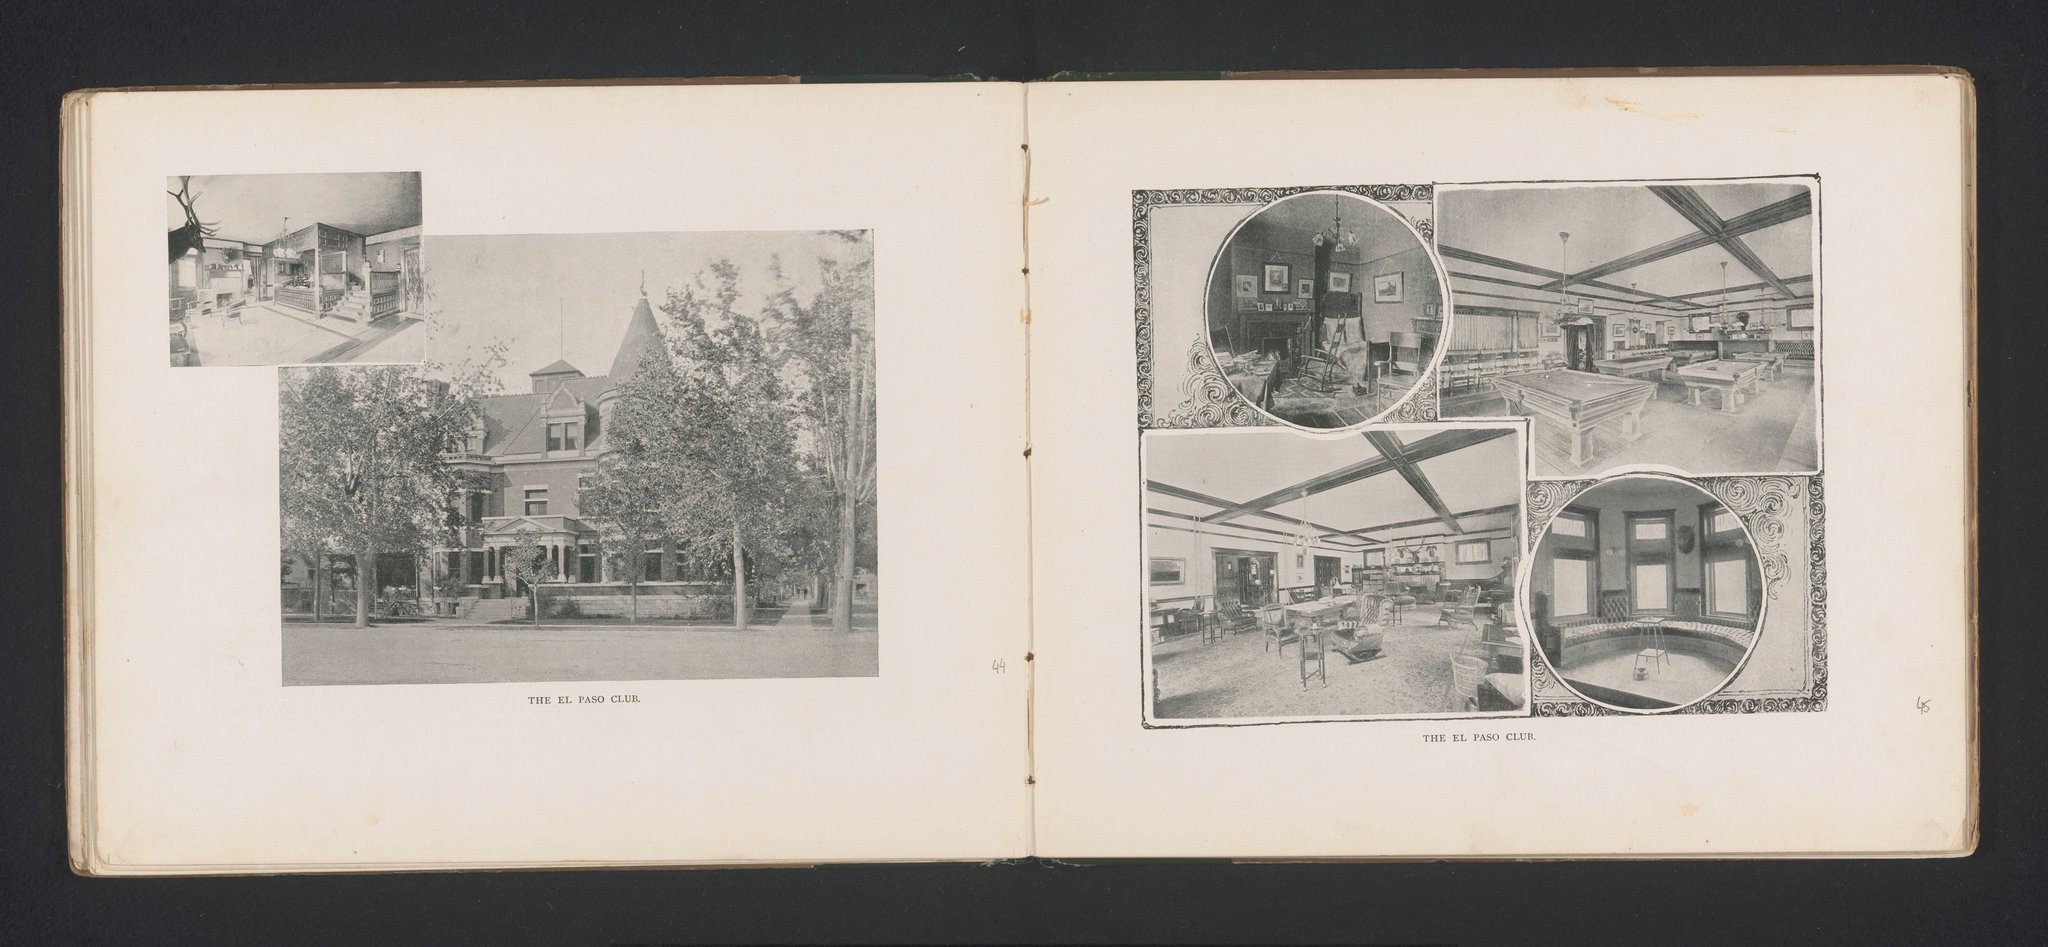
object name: photomechanical print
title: The El Paso Club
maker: Anonymous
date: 1888-1893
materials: paper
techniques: autotype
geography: colorado springs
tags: club, meeting place, living-room, parlour, sitting-room, other rooms